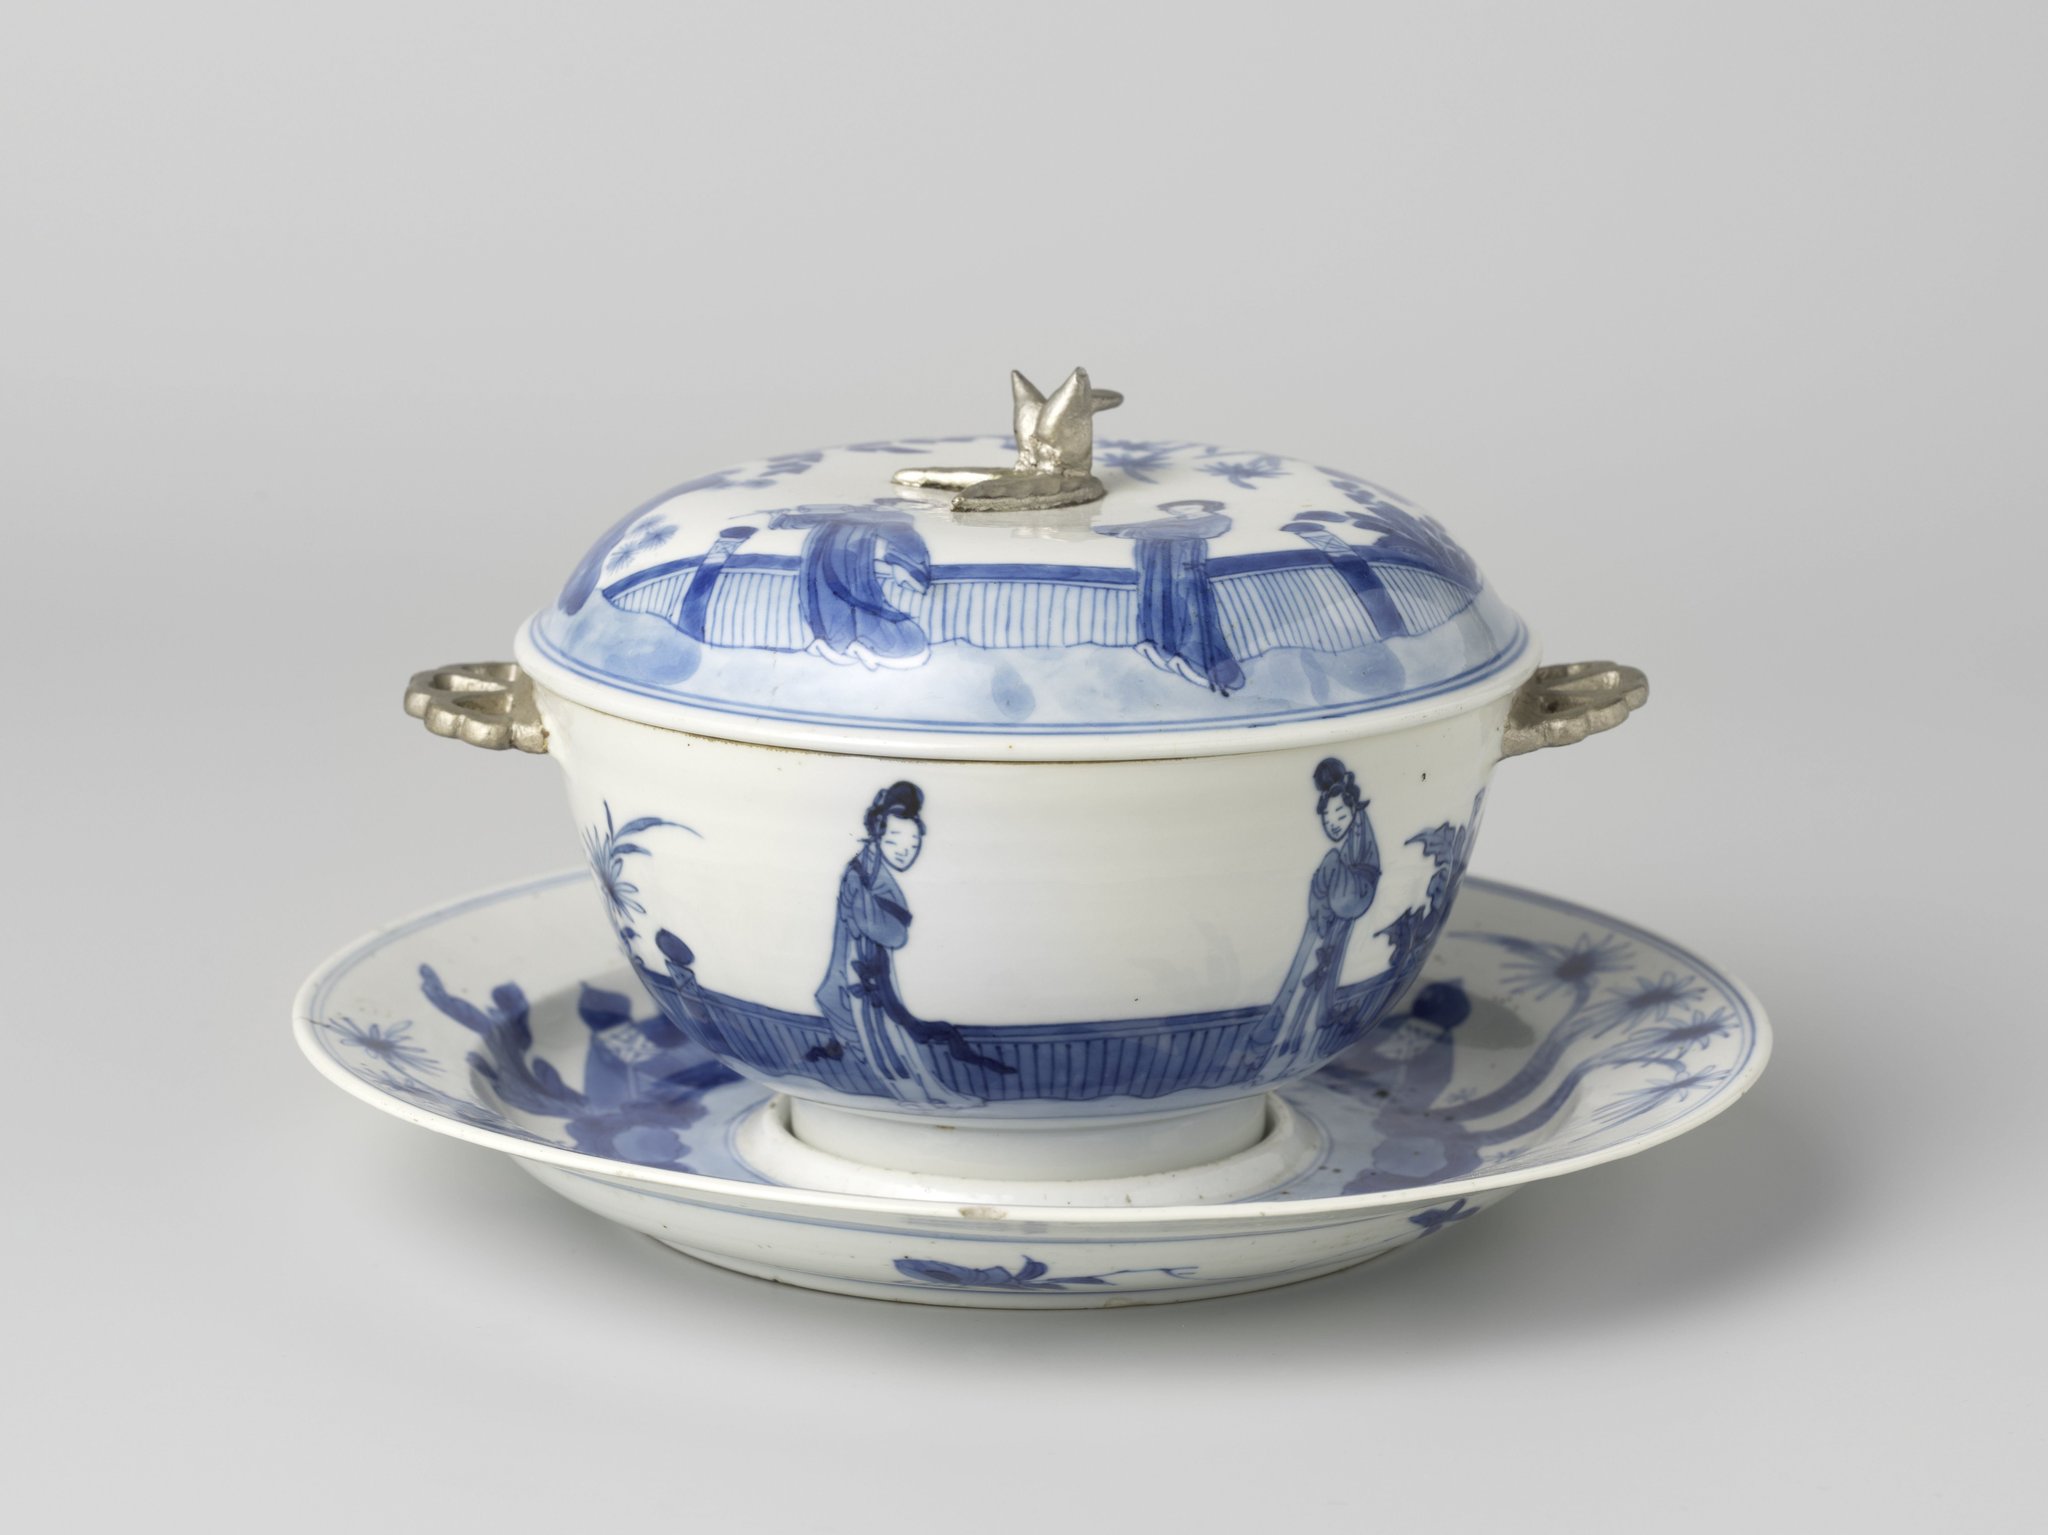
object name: covered bowl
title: Covered bowl with stand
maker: Anonymous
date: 1700-1724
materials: biscuit porcelain, cobalt, glaze, material), metal, paint, porcelain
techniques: firing, turning, vitrification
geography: china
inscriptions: mark: ‘大 清 康 熙 年 製’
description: Onderschotel van kom met deksel van porselein, beschilderd in onderglazuur blauw. Doorlopende voorstelling van een omheind terras met twee maal twee vrouwen (lange lijzen) afgebeeld, en vier palmbomen en twee bananenplanten. Op de achterzijde drie perziktakken. De onderzijde gemerkt met het zes-karaktermerk van keizer Kangxi in een dubbele cirkel. Een barst en een chip in de rand van de schotel. Blauw-wit.